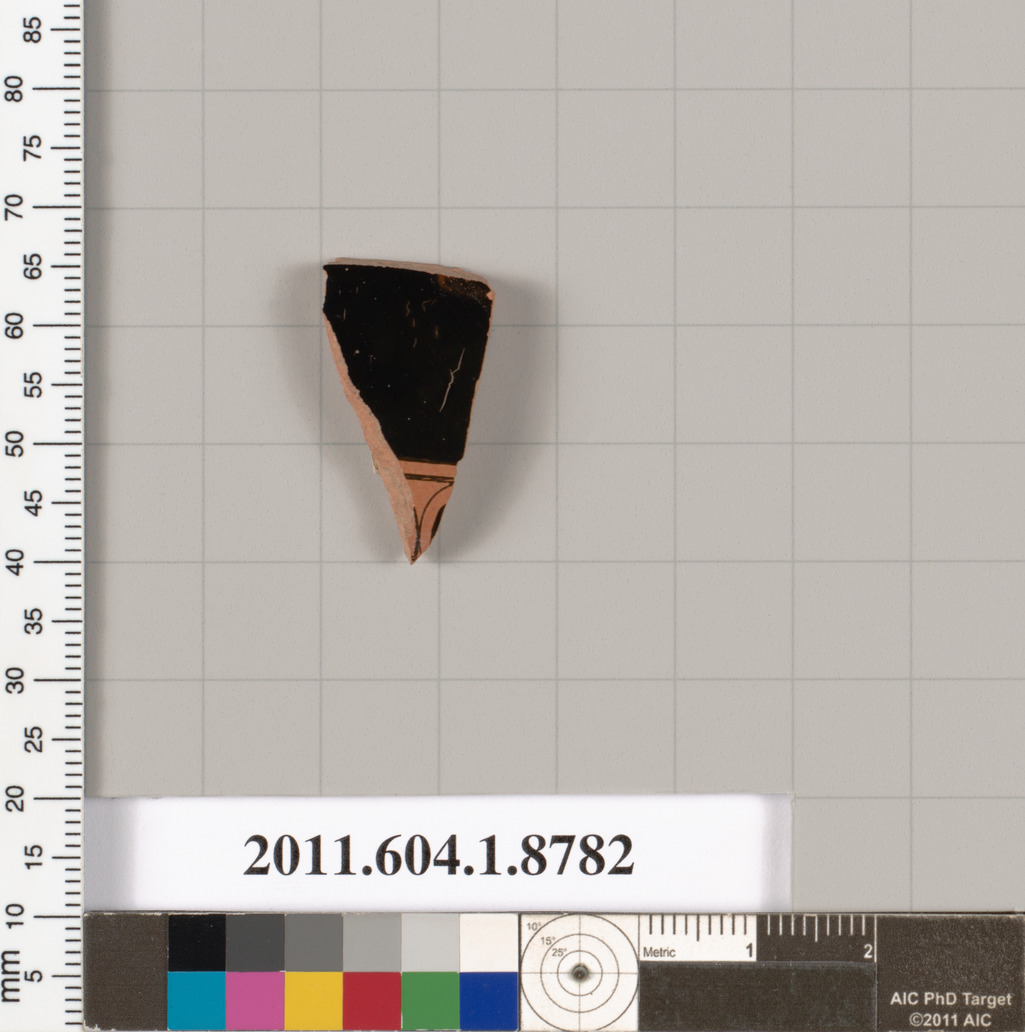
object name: kylix fragment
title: Terracotta fragment of a kylix (drinking cup)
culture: greek, attic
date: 480-470 BCE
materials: terracotta